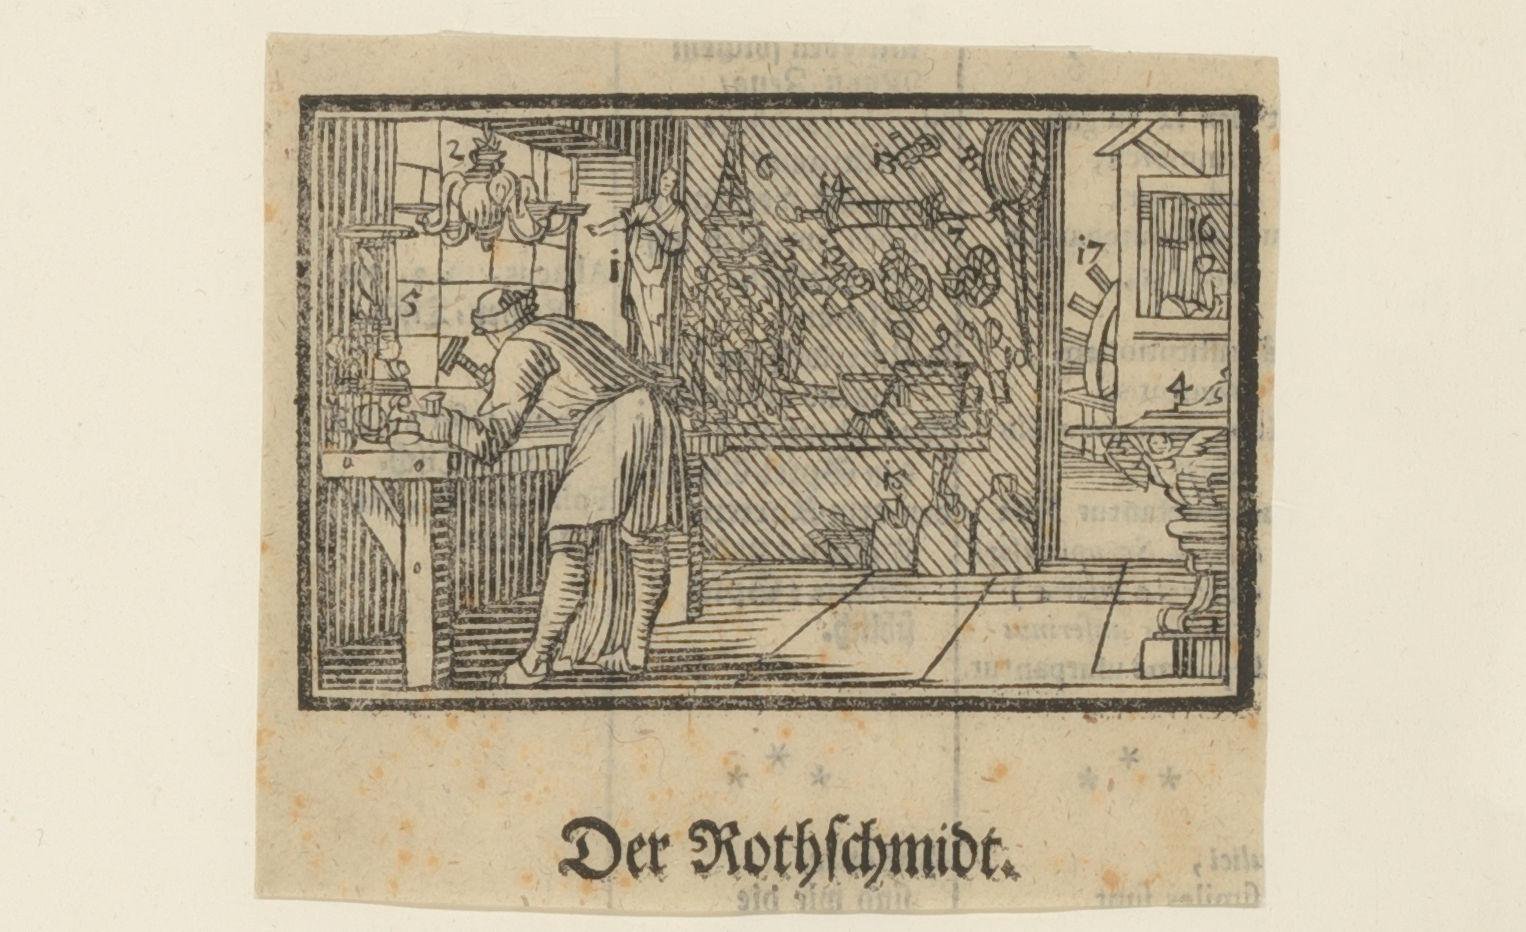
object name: book illustration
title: Der Rothschmidt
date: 1719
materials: paper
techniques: letterpress printing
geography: nuremberg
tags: handicrafts, craftsman at work, smith, blacksmith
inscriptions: stamp, collector's mark: Lugt 1641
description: Prent uit: Comenius, Johannes Amosius. Orbis sensualium picti pars prima (...). Neurenberg: Martin Endter, 1719, dl. 2, p. 118. Prent eerder gebruikt in: Comenius, Johannes Amosius. Orbis Sensualium Picti denuo aucti Pars Secunda (...). Neurenberg: Martin Endter, 1730, dl. 2.